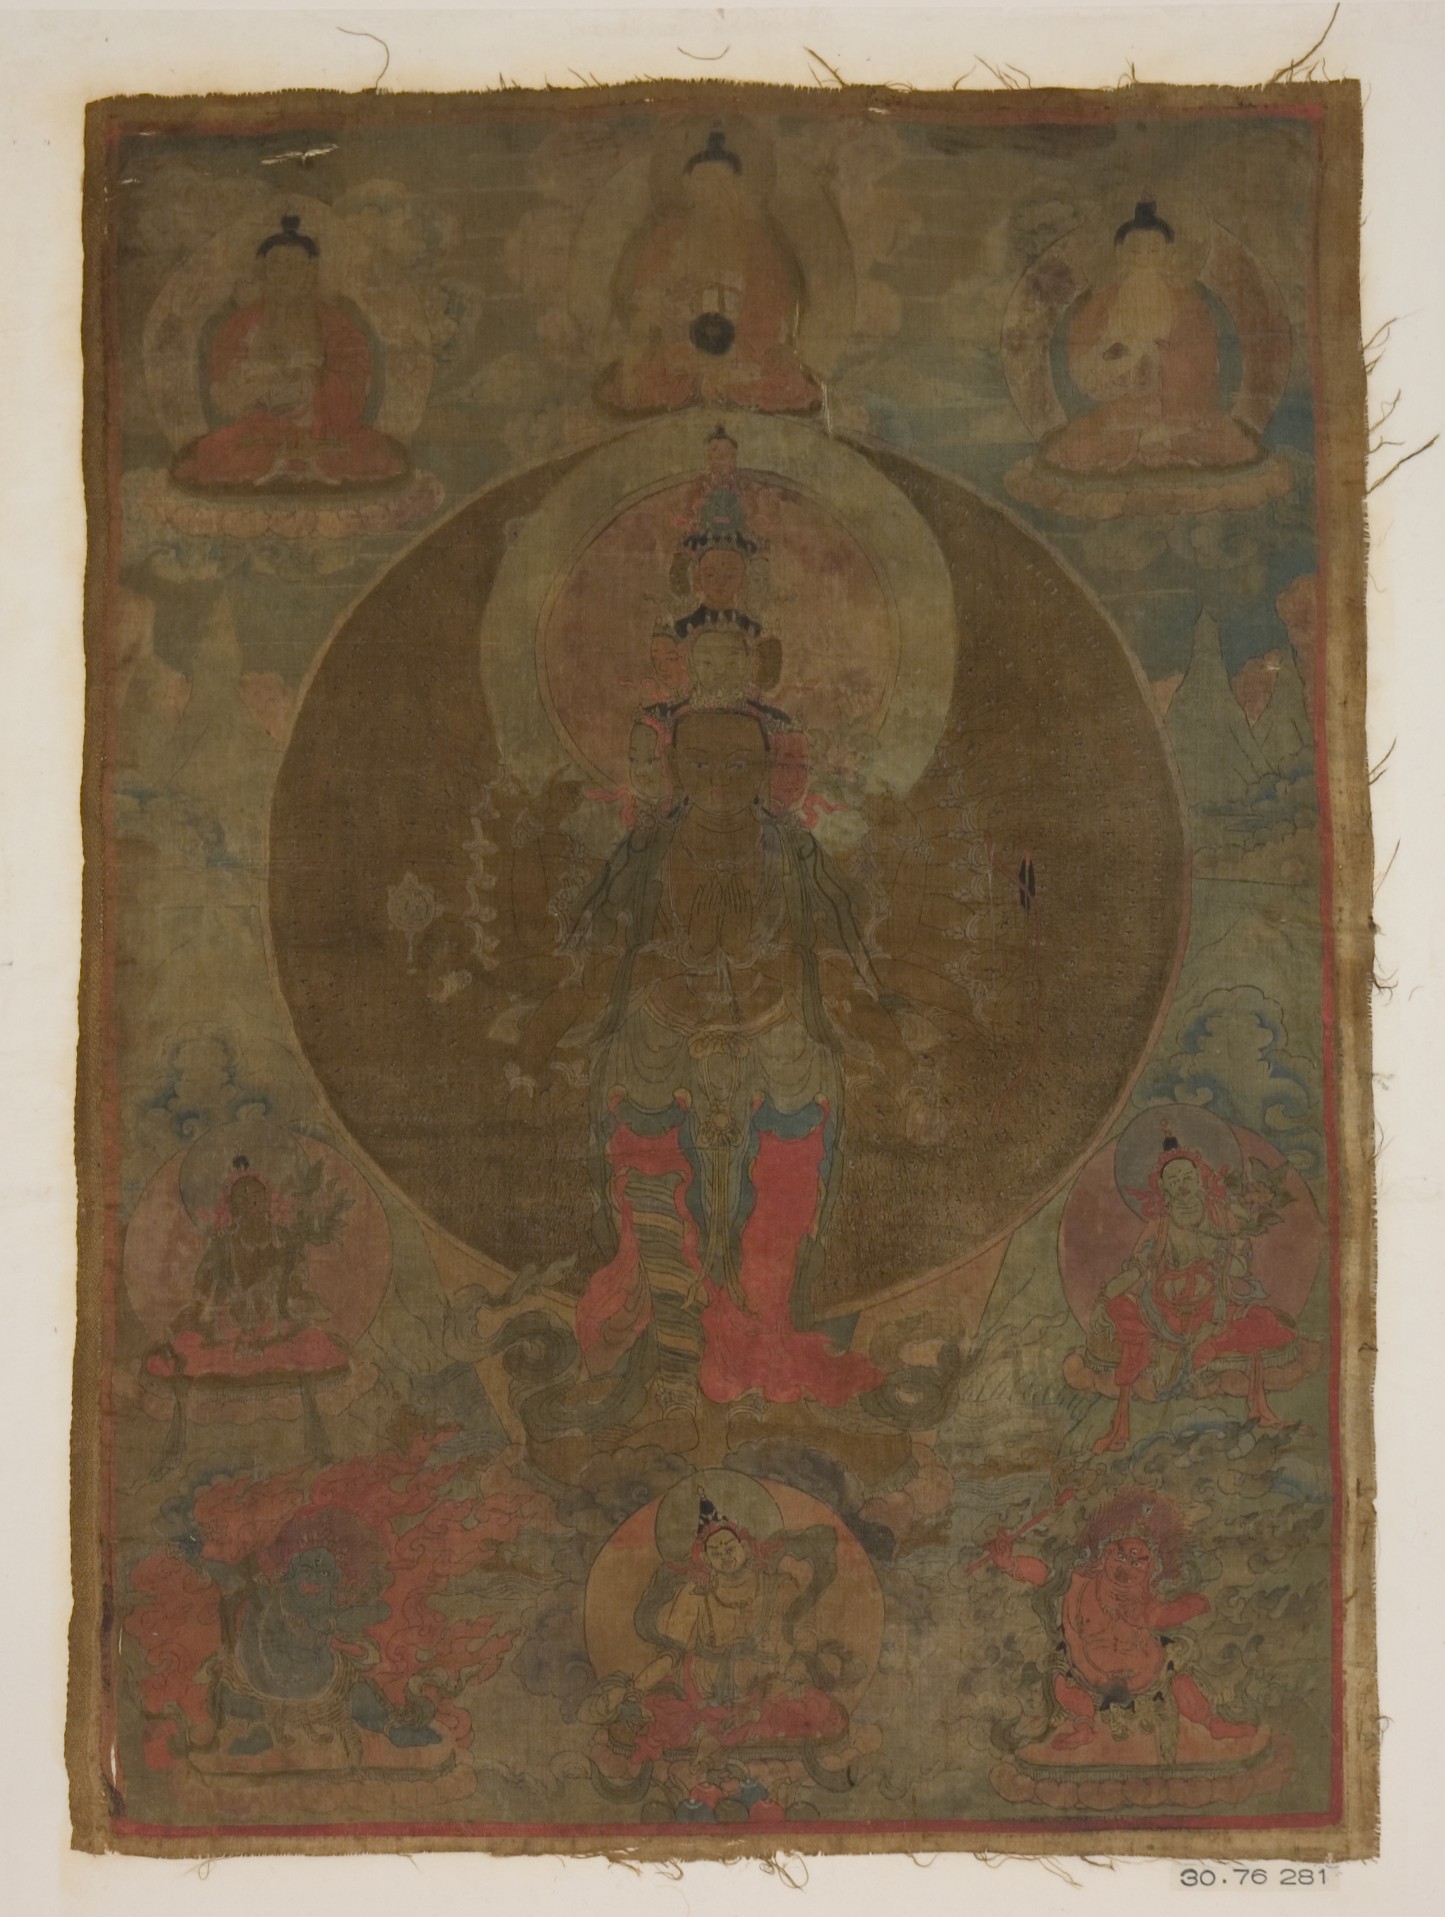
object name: thangka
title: Panel from Painting of a Thousand-Armed Guanyin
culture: tibetan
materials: silk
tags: buddhism,bodhisattvas